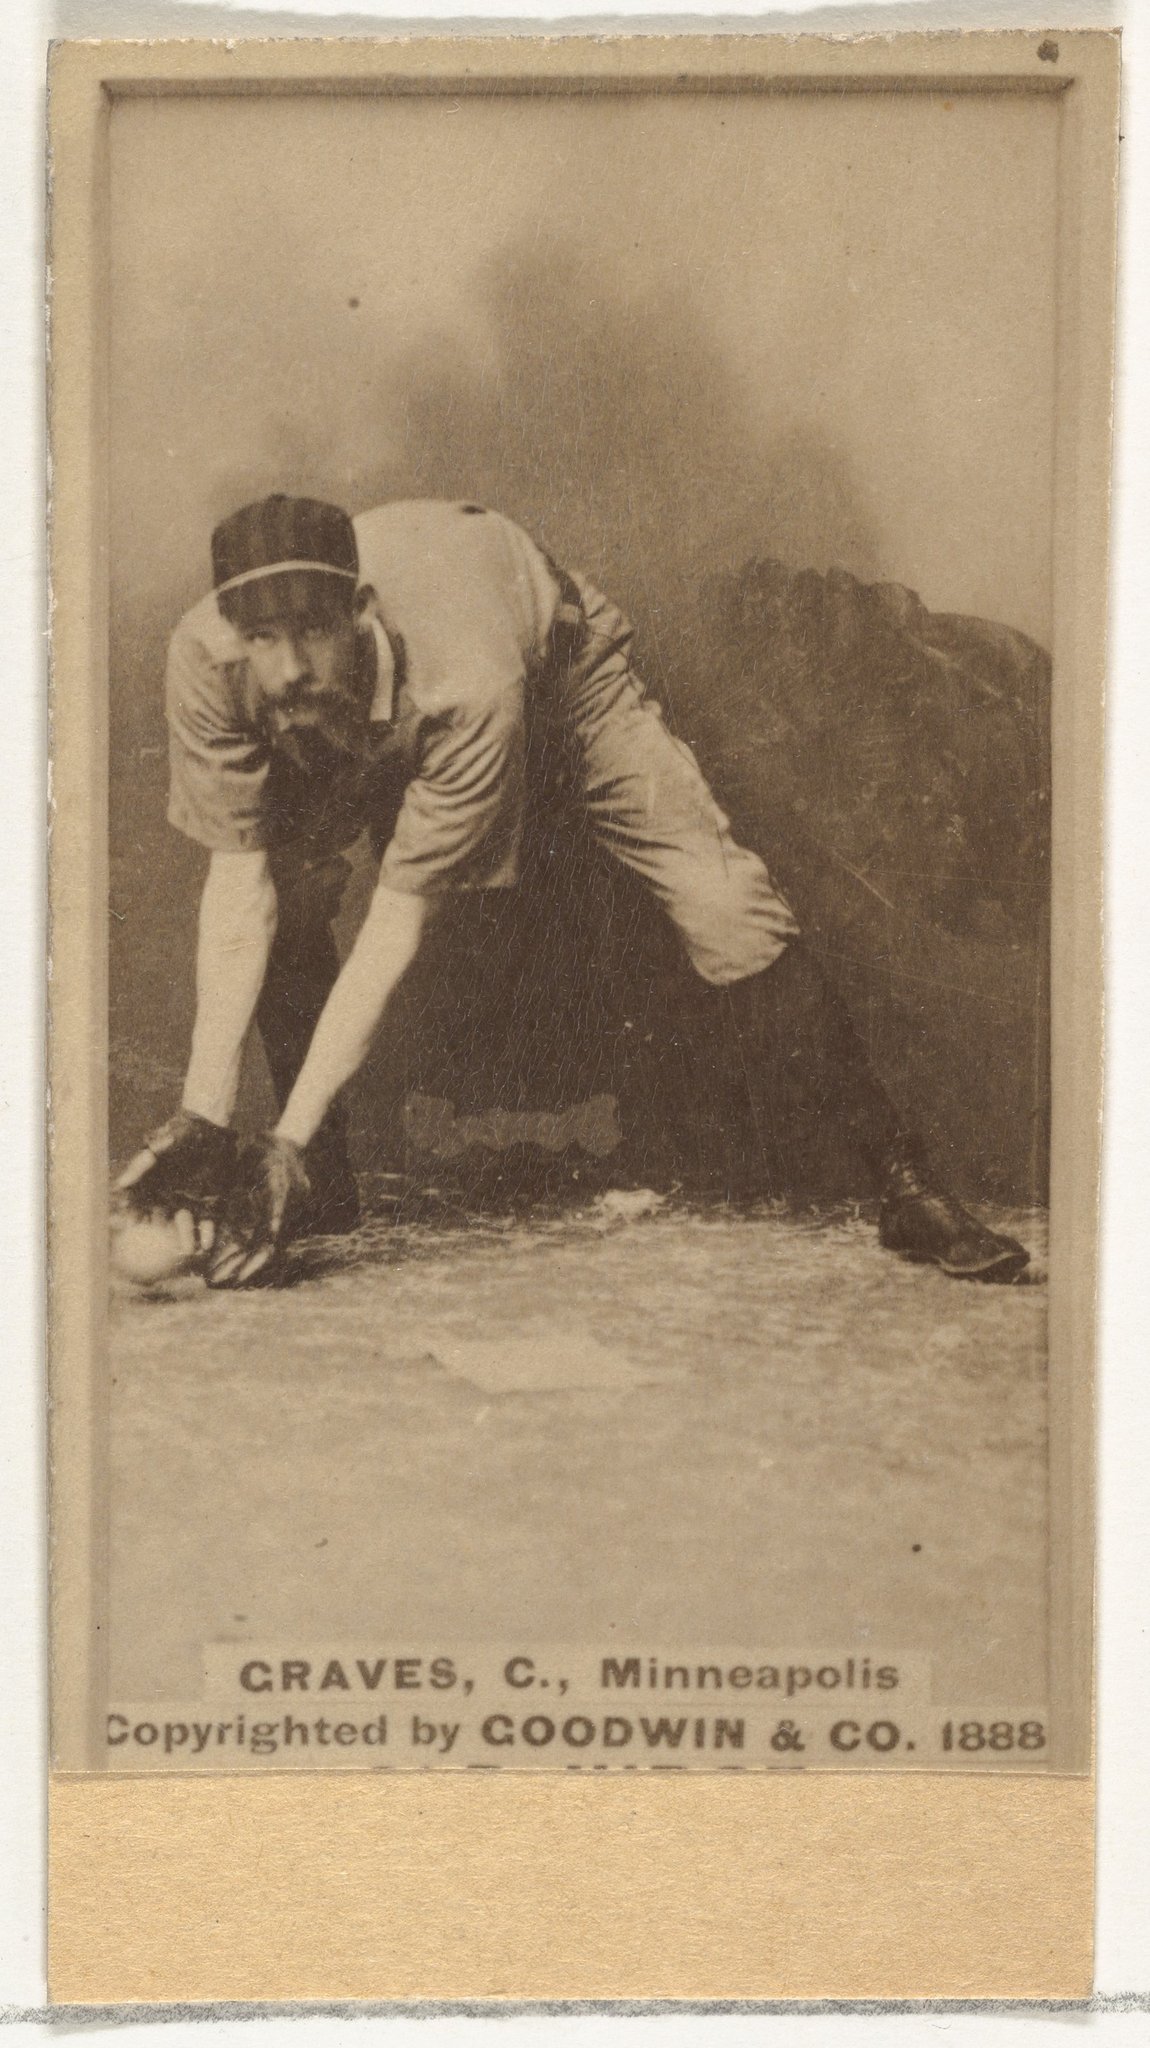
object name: baseball card, photograph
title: Frank Norris Graves, Catcher, Minneapolis, from the Old Judge series (N172) for Old Judge Cigarettes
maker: goodwin & company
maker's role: publisher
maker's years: 1850-1950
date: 1888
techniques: albumen silver print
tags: men,portraits,baseball,athletes